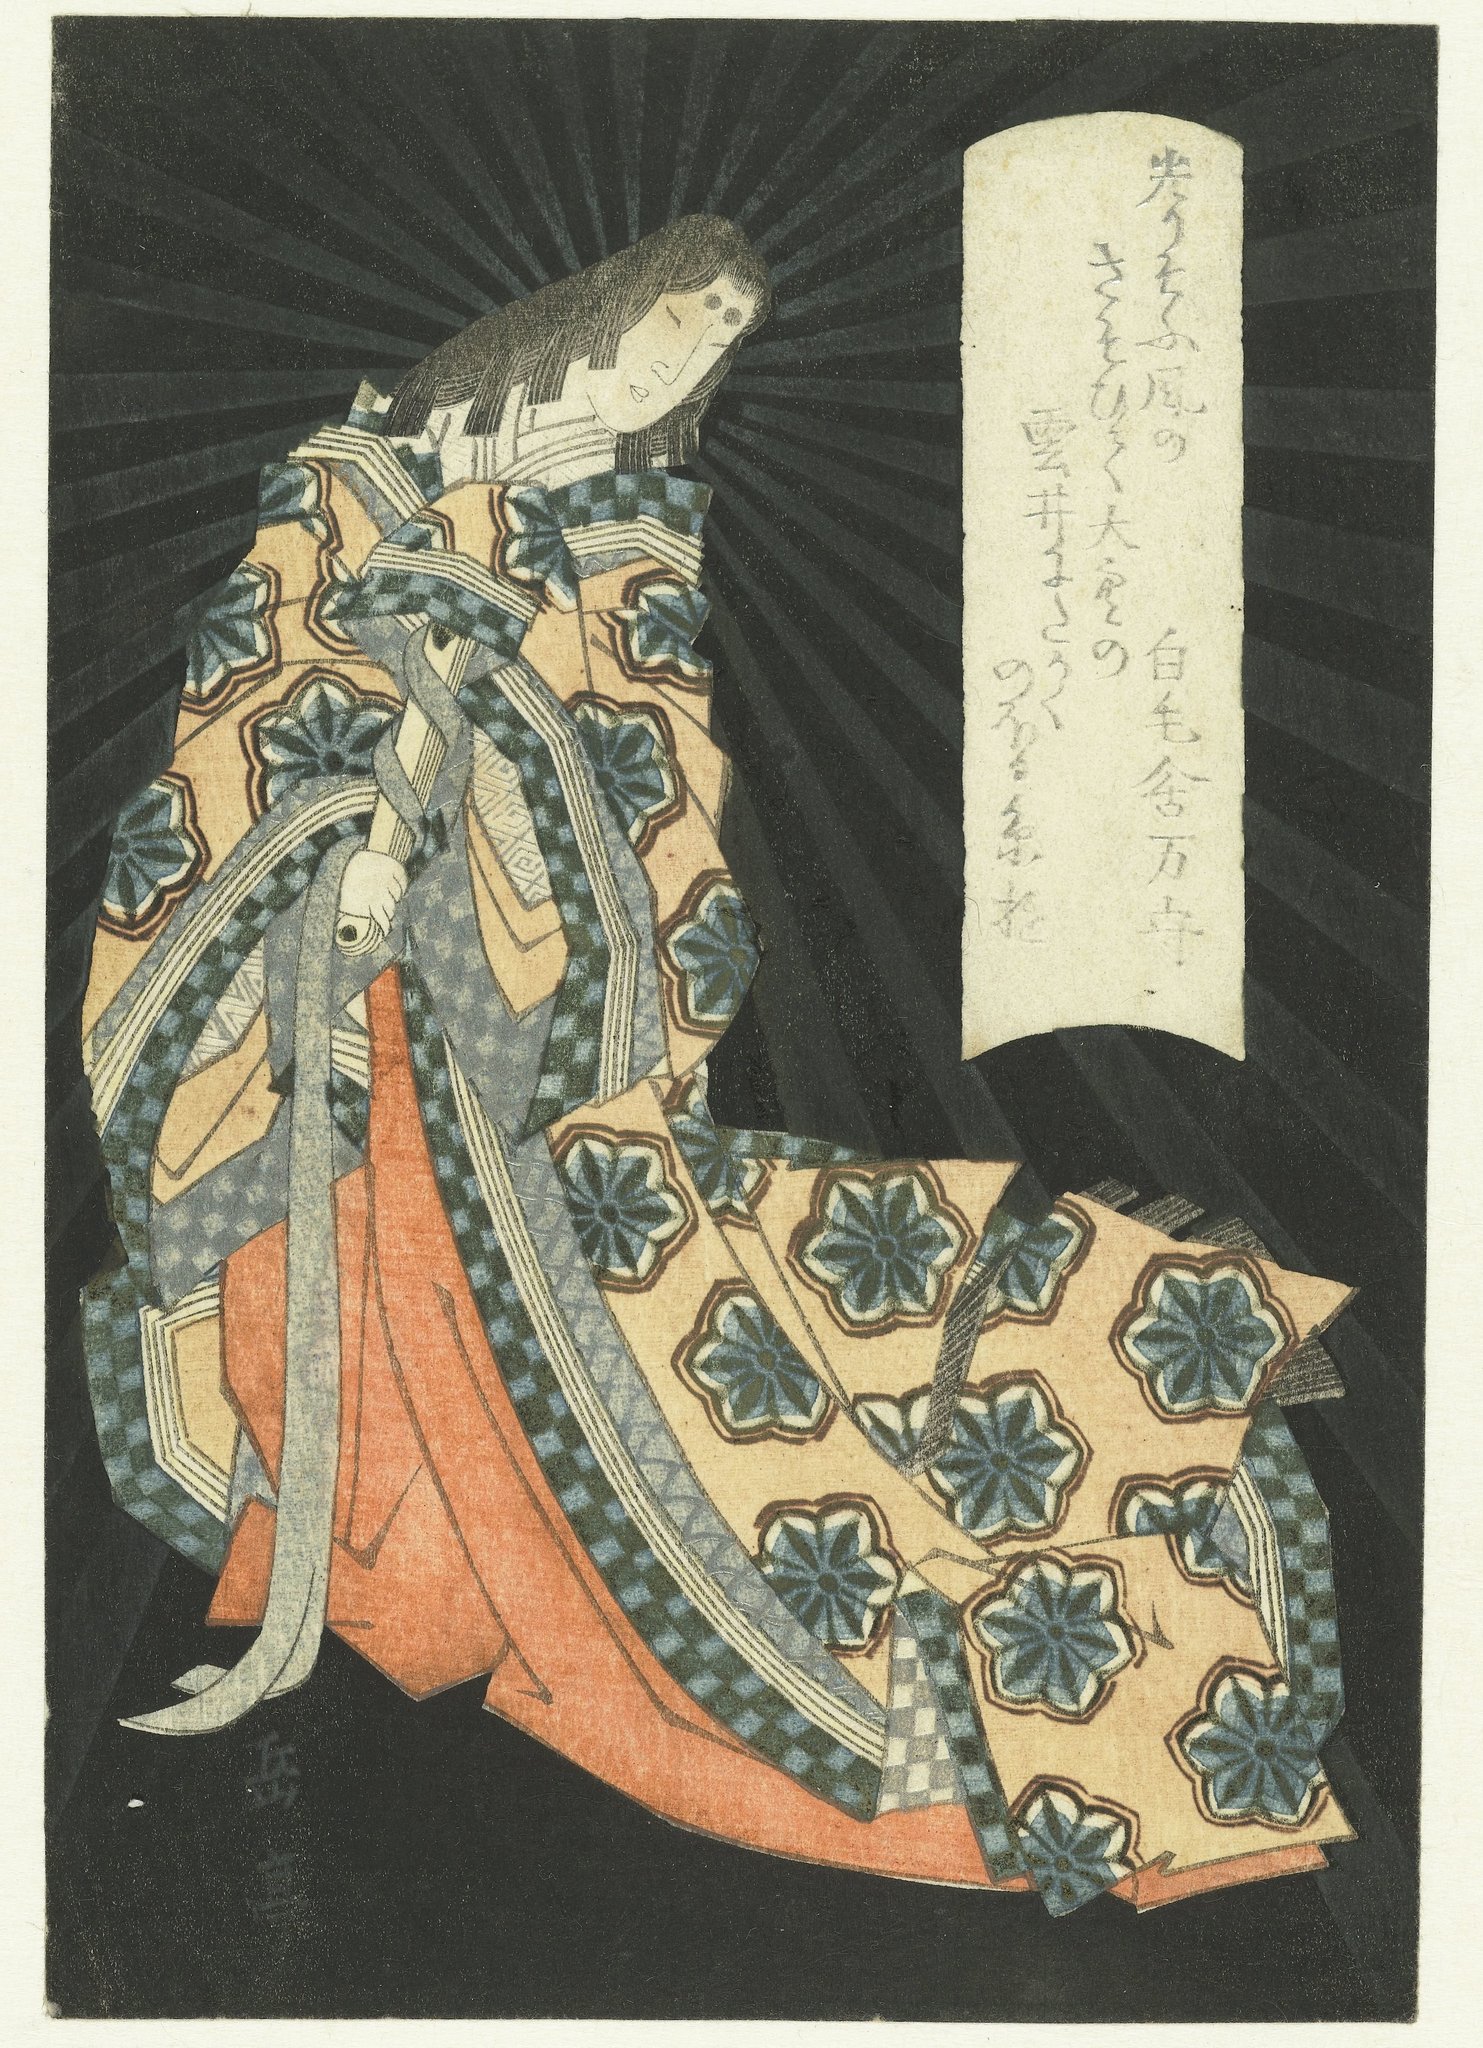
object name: surimono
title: A standing Court Lady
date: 1828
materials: paper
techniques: woodcut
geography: japan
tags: adult woman, fan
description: Een surimono is een luxe uitgevoerde prent waarop beeld met één of meerdere gedichten gecombineerd is. Bij het drukken van een surimono werd vaak gebruik gemaakt van dikker papier, blinddruk en metaal pigmenten, zoals koper- en zilverpoeder. De prenten werden vaak in opdracht van dichters gemaakt en als exclusief geschenk aan vrienden en relaties gegeven.